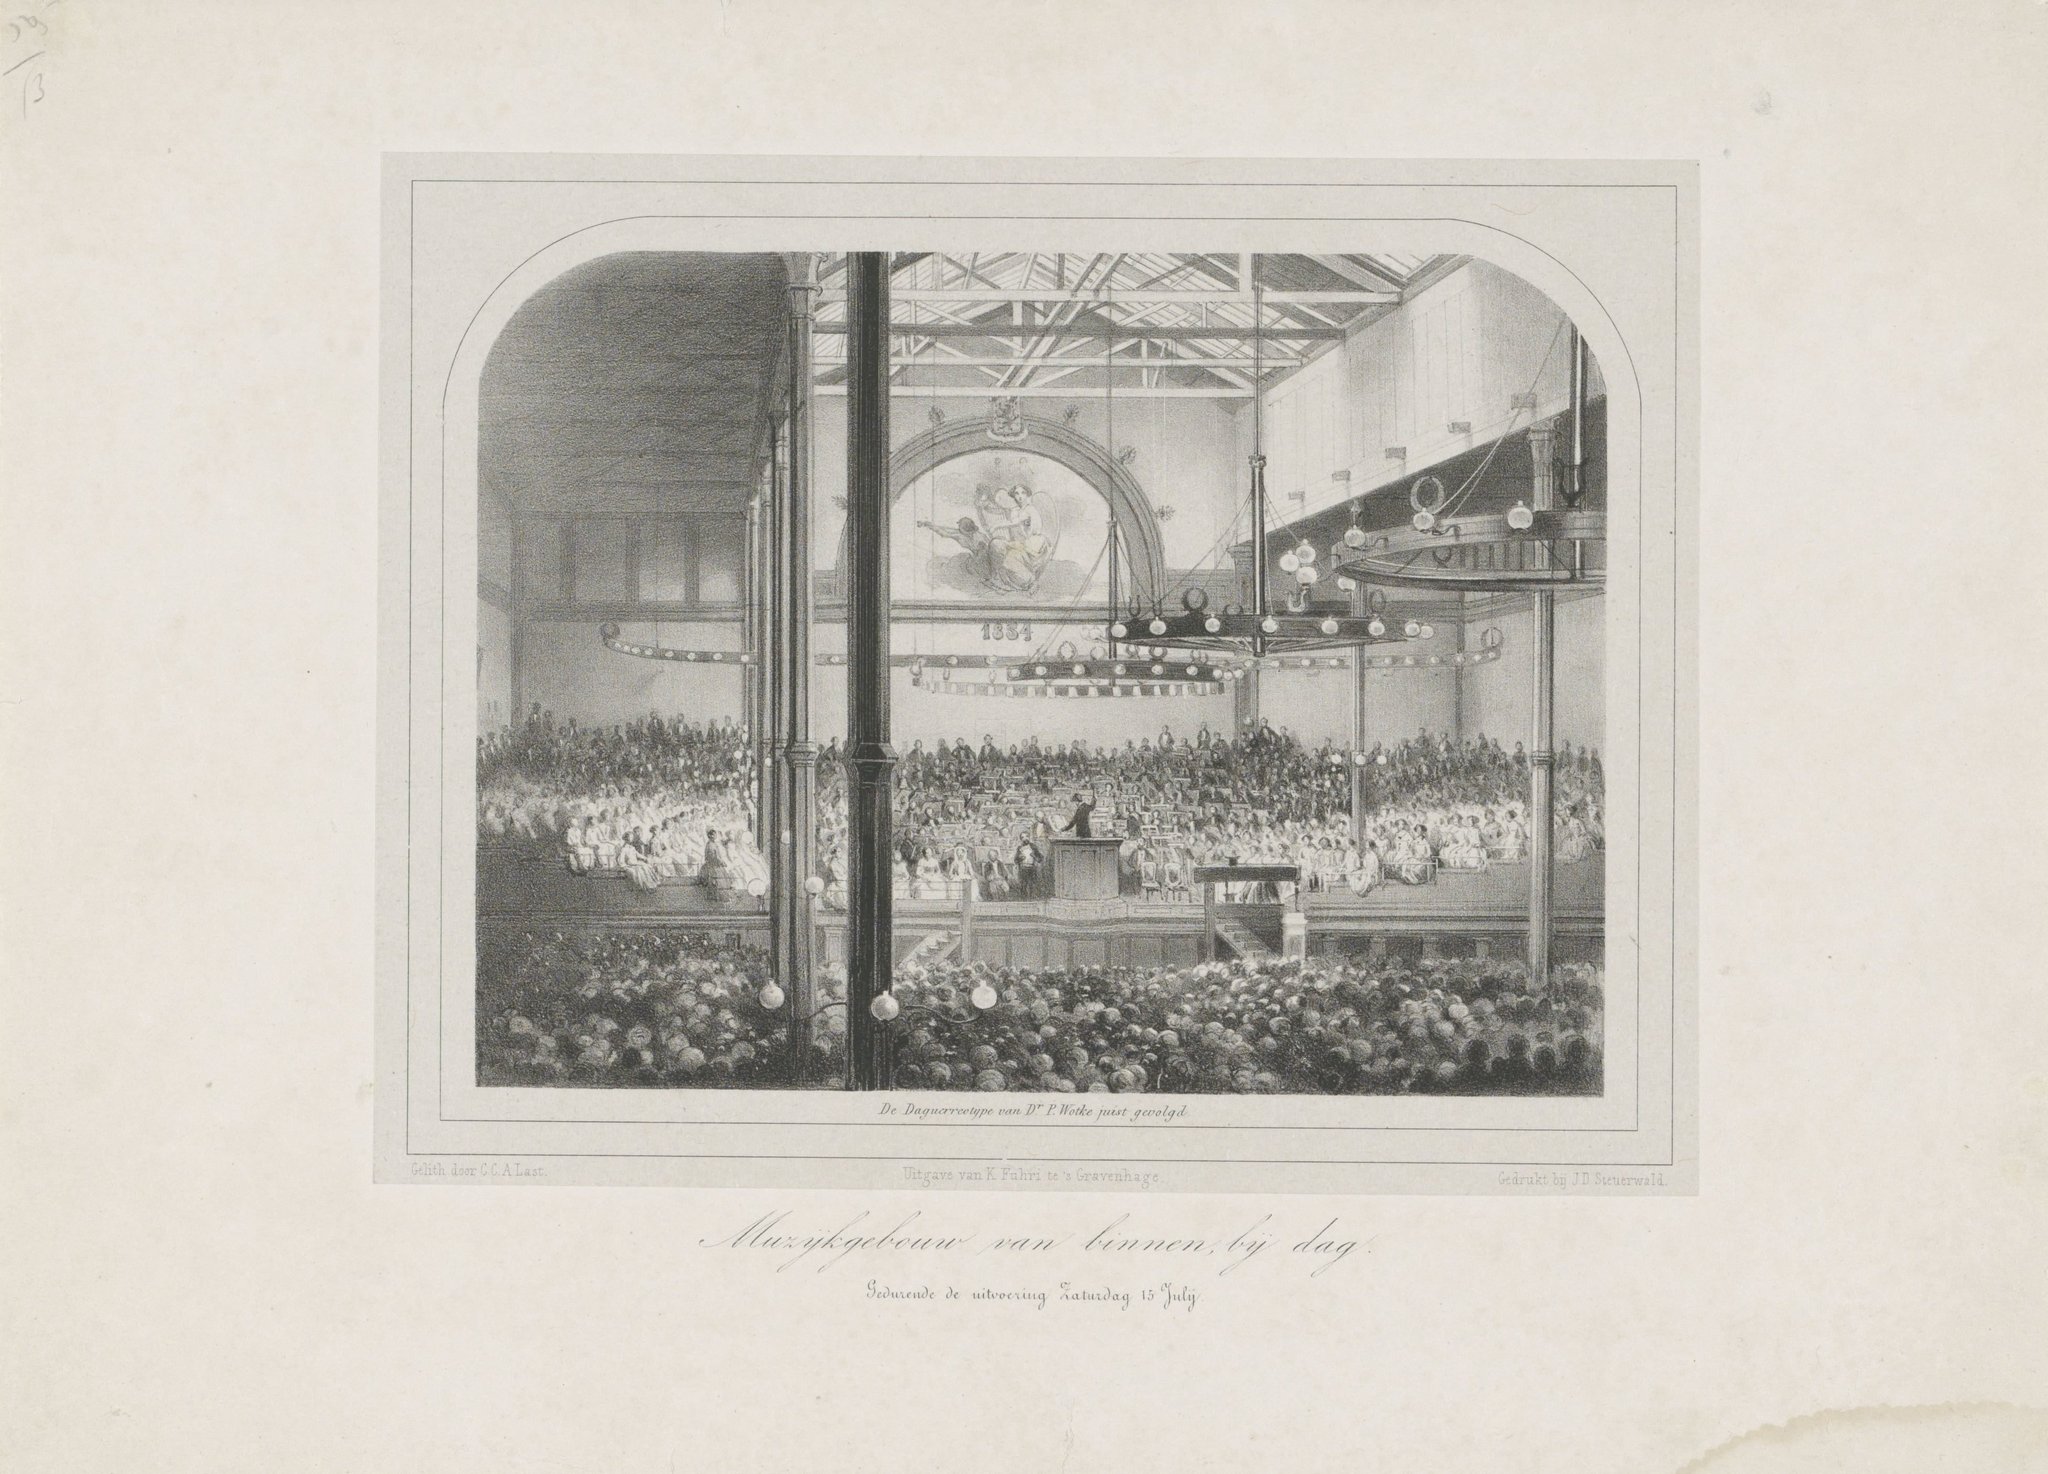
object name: print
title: Muzijkgebouw van binnen, bij dag. Gedurende de uitvoering Zaturdag 15 July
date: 1855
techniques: printmaking, lithograph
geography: the hague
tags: large group of musicians, orchestra, concert hall, rotterdam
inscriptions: collector's mark: Lugt 2228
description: Gezicht in het interieur van het nieuwe Feestgebouw waar in het kader van het muziekfeest een concert wordt gegeven, 15 juli 1854. Onderdeel van een serie van twaalf portretten naar daguerrotypieën en twaalf stadsgezichten. Ter gelegenheid van het Muziekfeest ter viering van het 25-jarige bestaan van de Maatschappij ter Bevordering van Toonkunst in Rotterdam, 12-15 juli 1854.